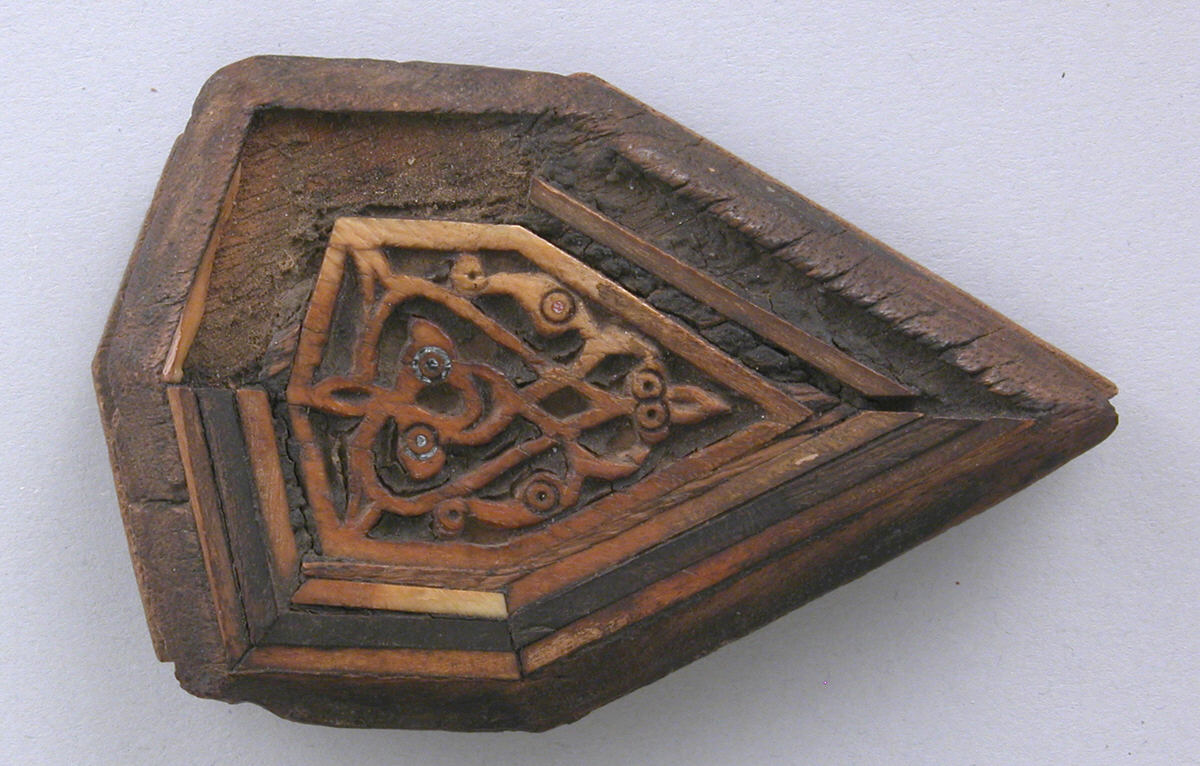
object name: panel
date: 1201-1400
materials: ivory, wood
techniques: carving, inlay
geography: egypt